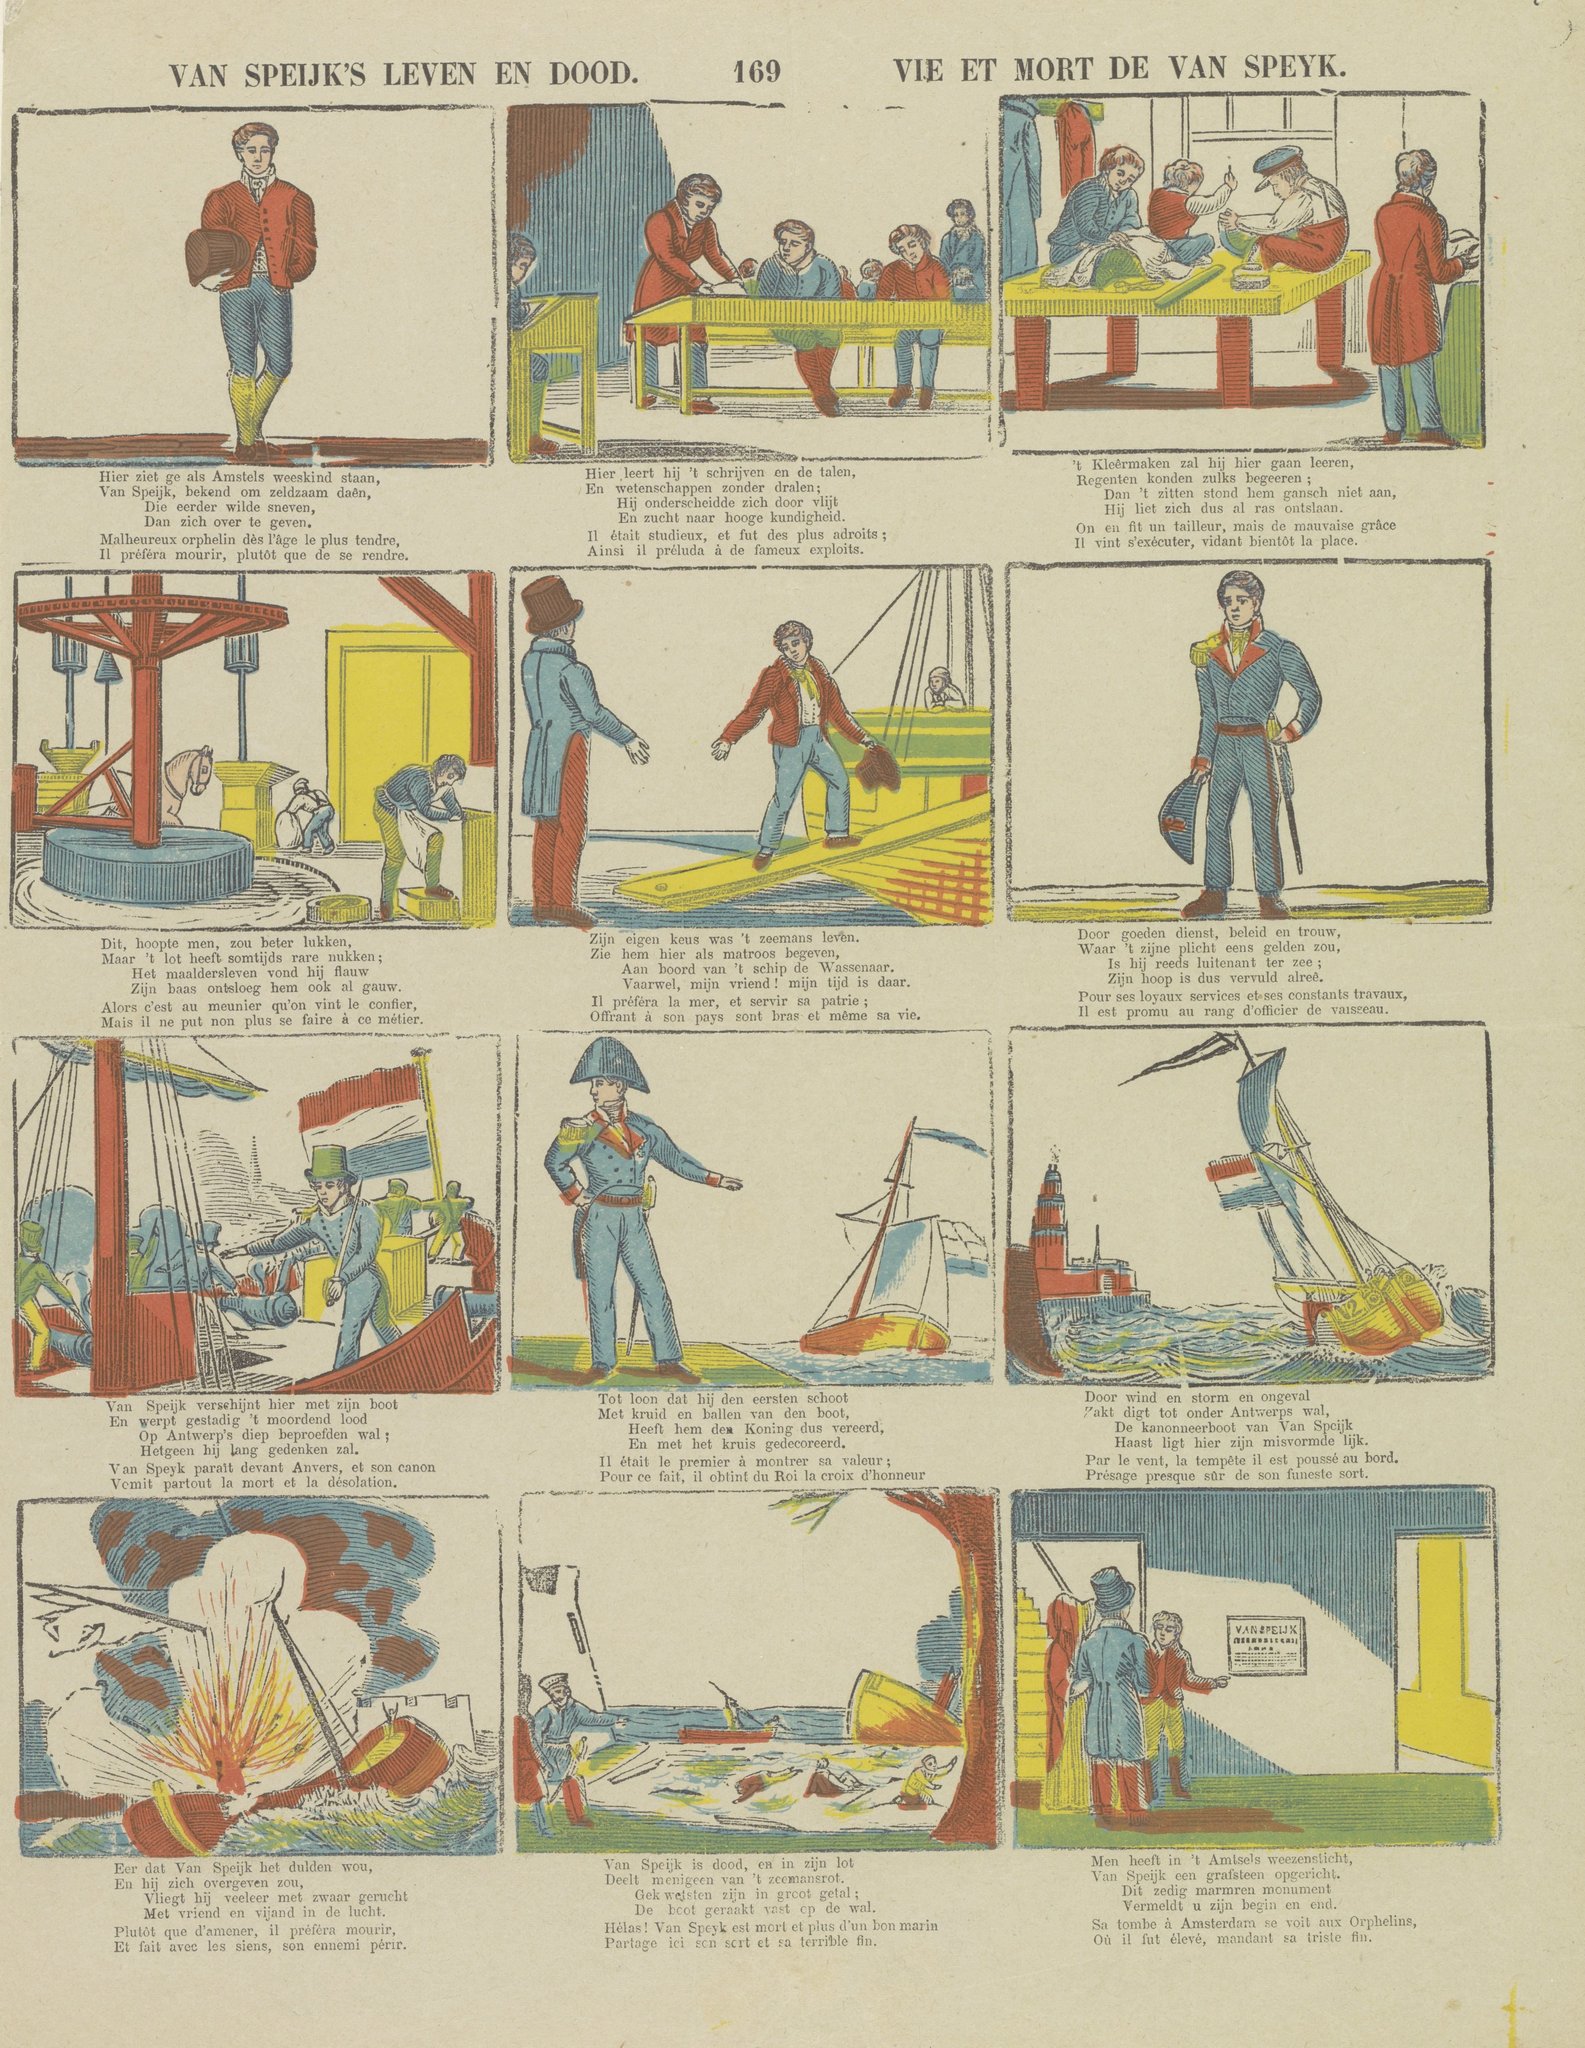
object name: print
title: Van Speijk's leven en dood / Vie et mort de Van Speyk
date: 1800-1833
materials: paper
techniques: lithograph, letterpress printing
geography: turnhout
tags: antwerp, jan van speyk, battle, revolution, revolt, orphans, belgium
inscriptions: collector's mark: Lugt 2760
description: Blad met 12 voorstellingen over het leven en de zelfopoffering van J.C.J. van Speyk tijdens de strijd tegen de Belgen. Onder elke afbeelding een vierregelig vers in het Nederlands en een tweeregelig vers in het Frans. Genummerd midden boven: 169.